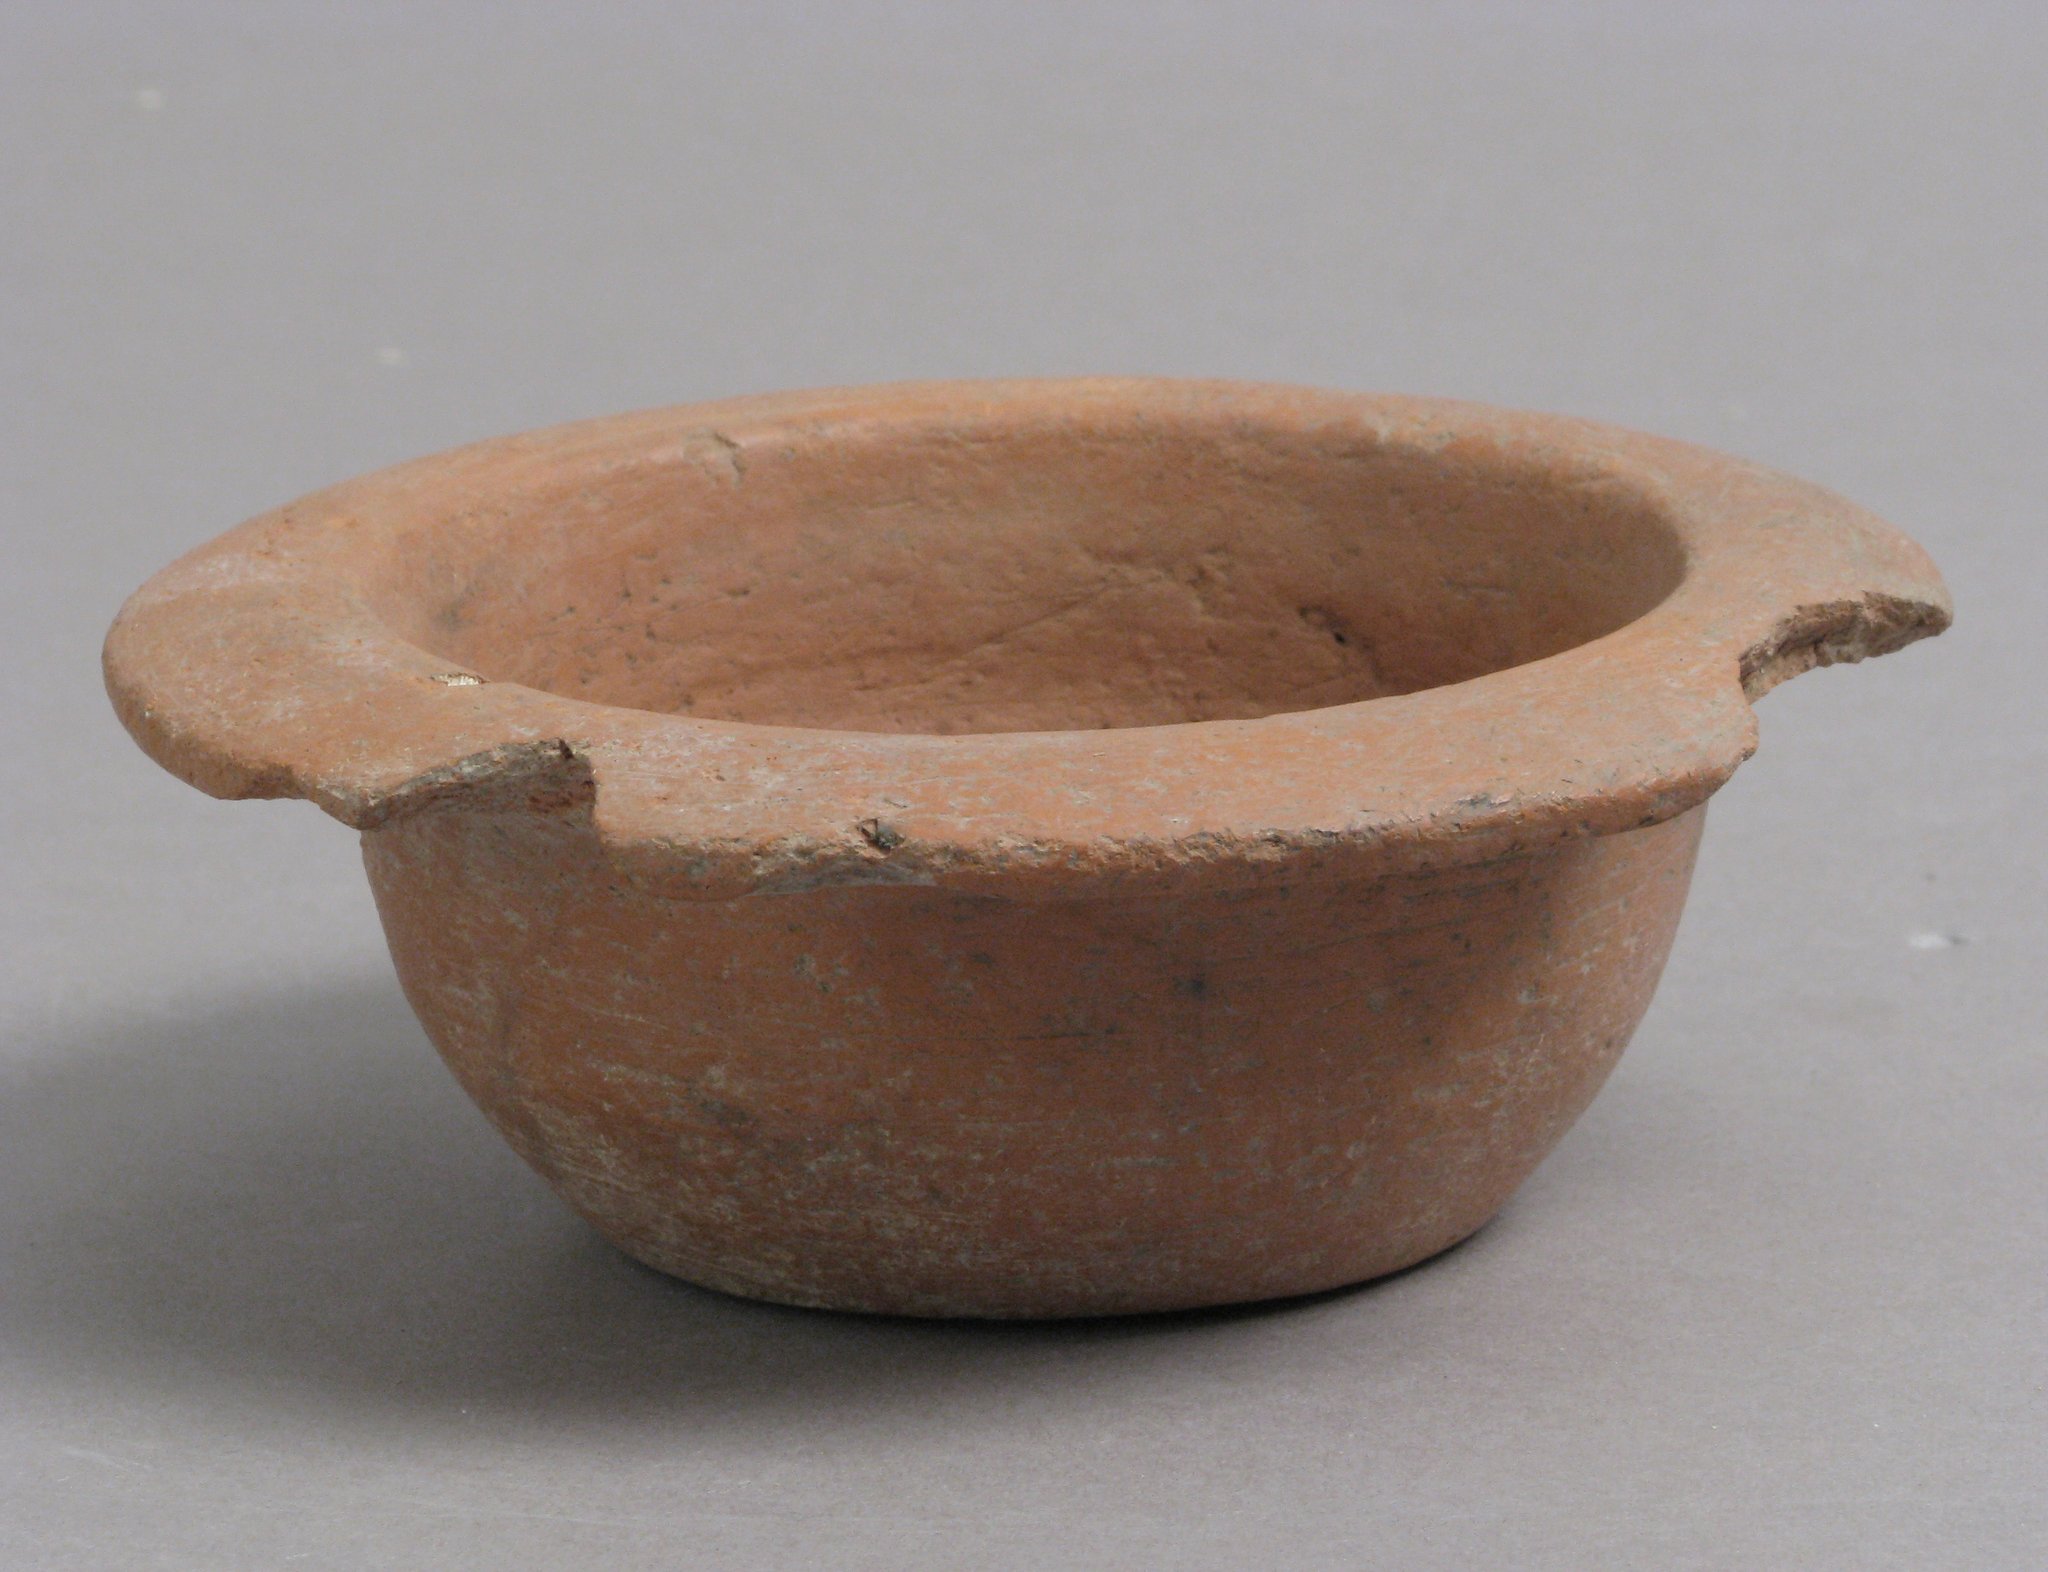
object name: bowl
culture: coptic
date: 301-700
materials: earthenware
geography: egypt